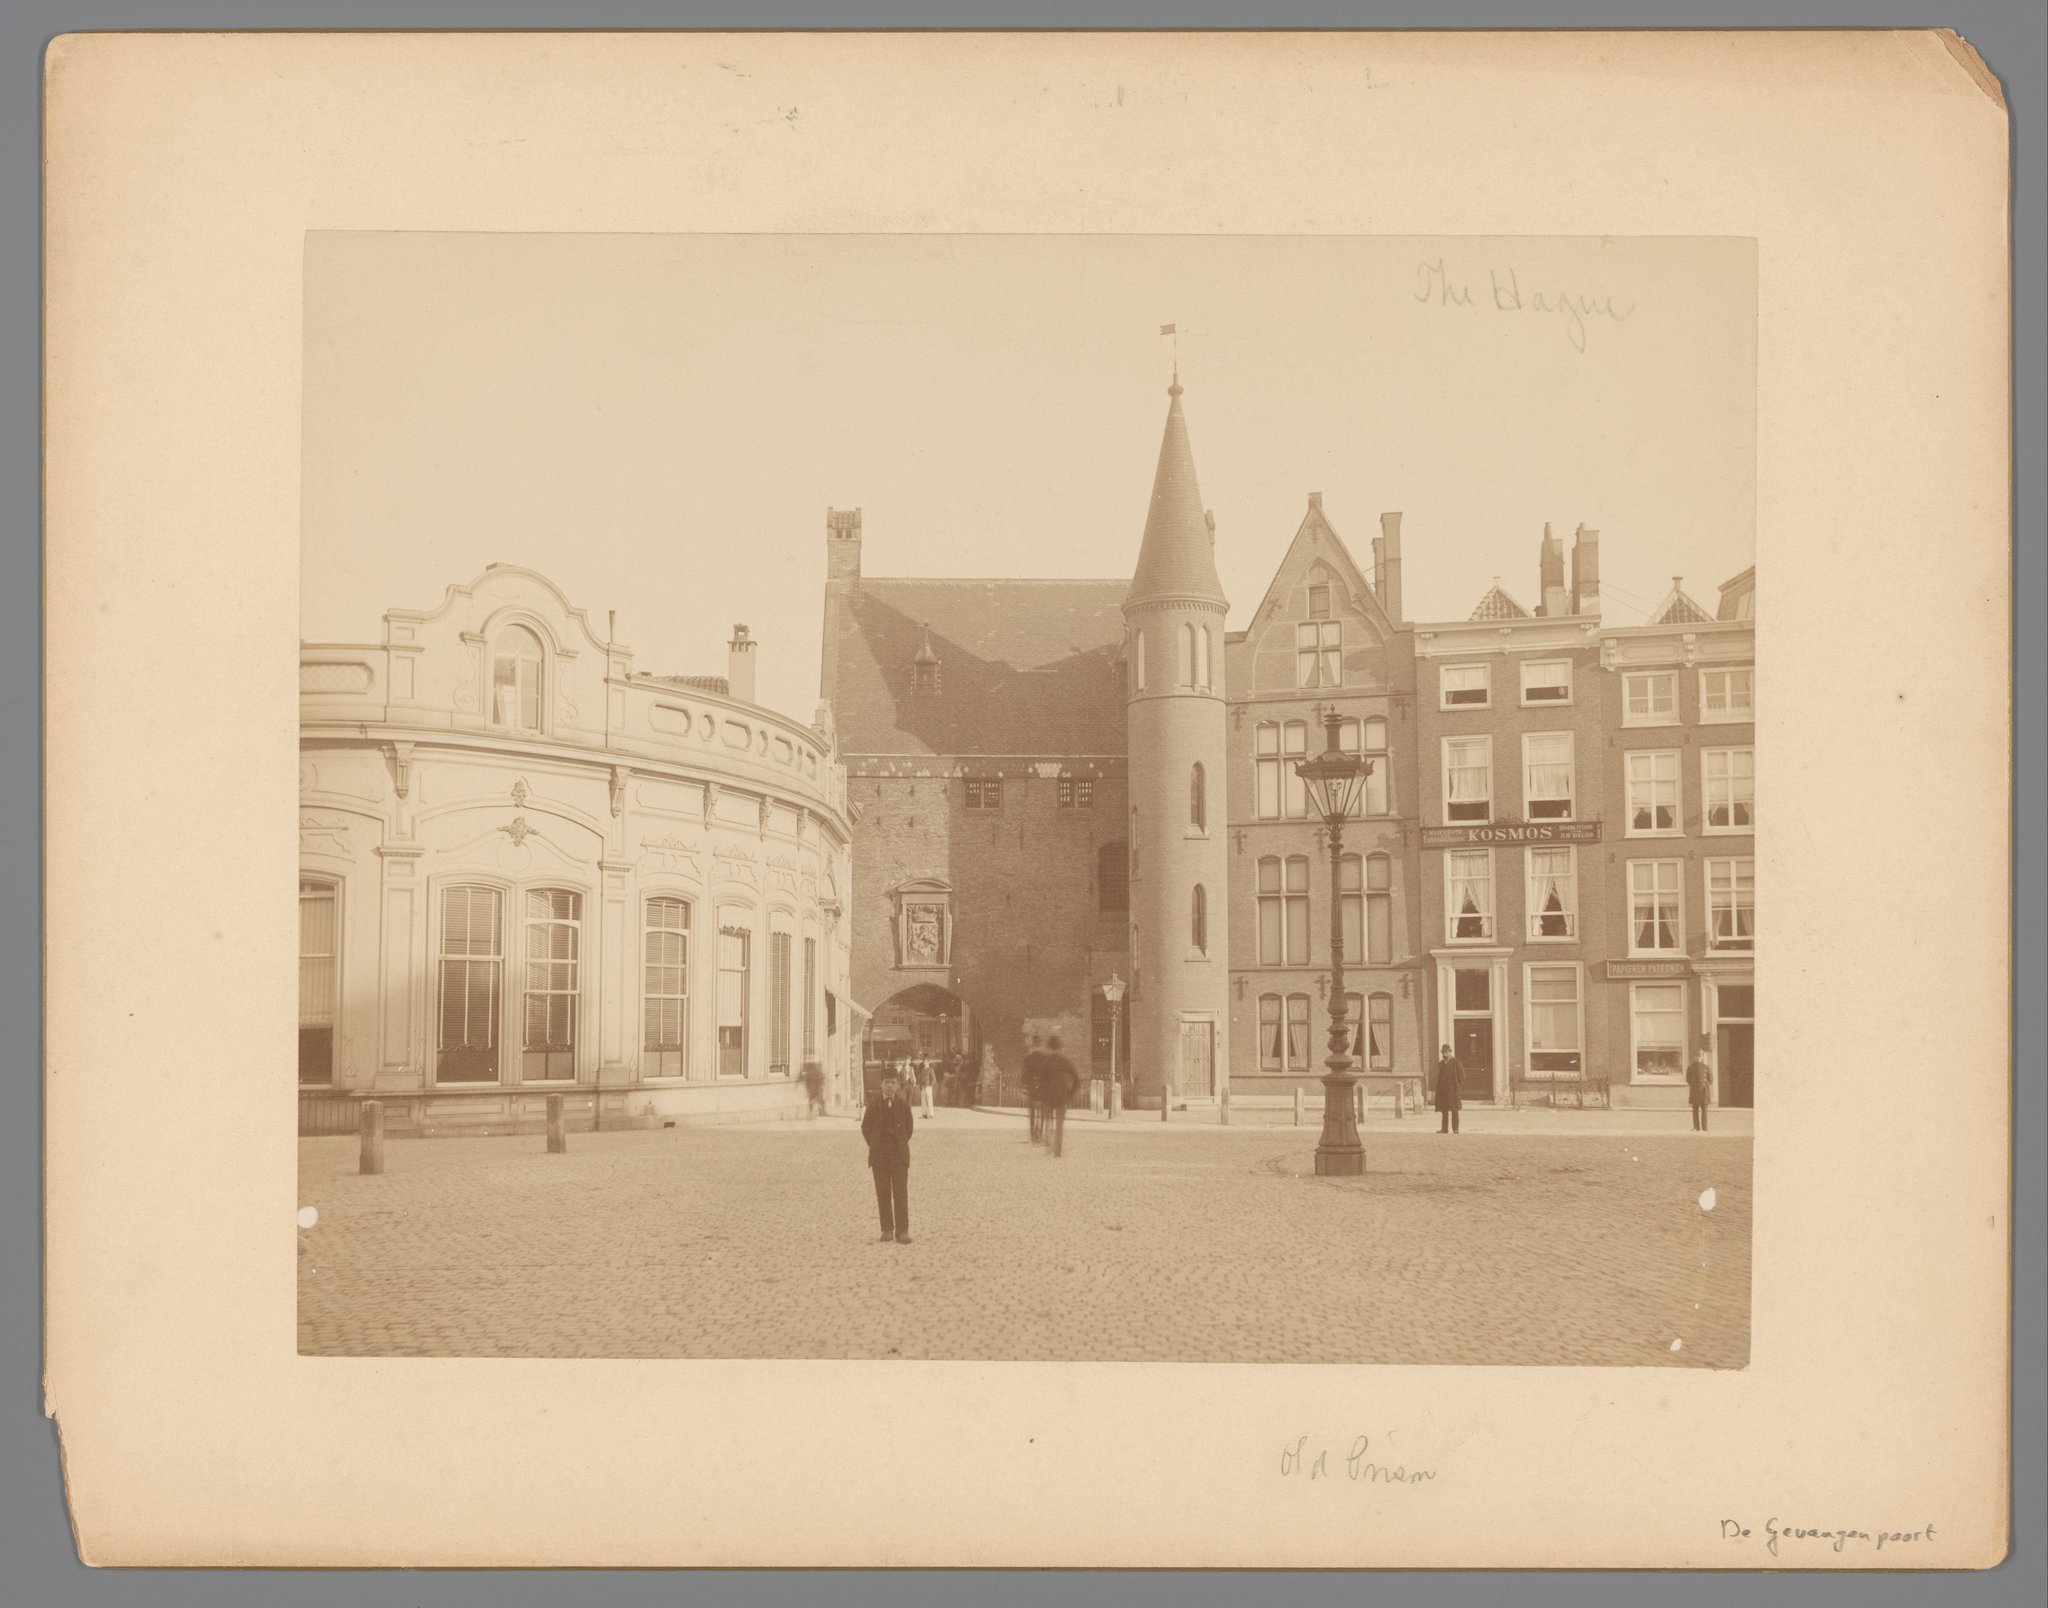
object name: photograph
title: Gezicht op de Gevangenpoort te Den Haag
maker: Anonymous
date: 1900-1960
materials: cardboard, photographic support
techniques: albumen print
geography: the hague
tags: square, place, circus, etc. (+ city(-scape) with figures, staffage)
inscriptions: annotation: ‘The Hague/ [H A Priem]/ de Gevangenpoort’, annotation: ‘Geschonken door de Historical Society of Western Pennsylvania, Pittsburgh/ 1990’